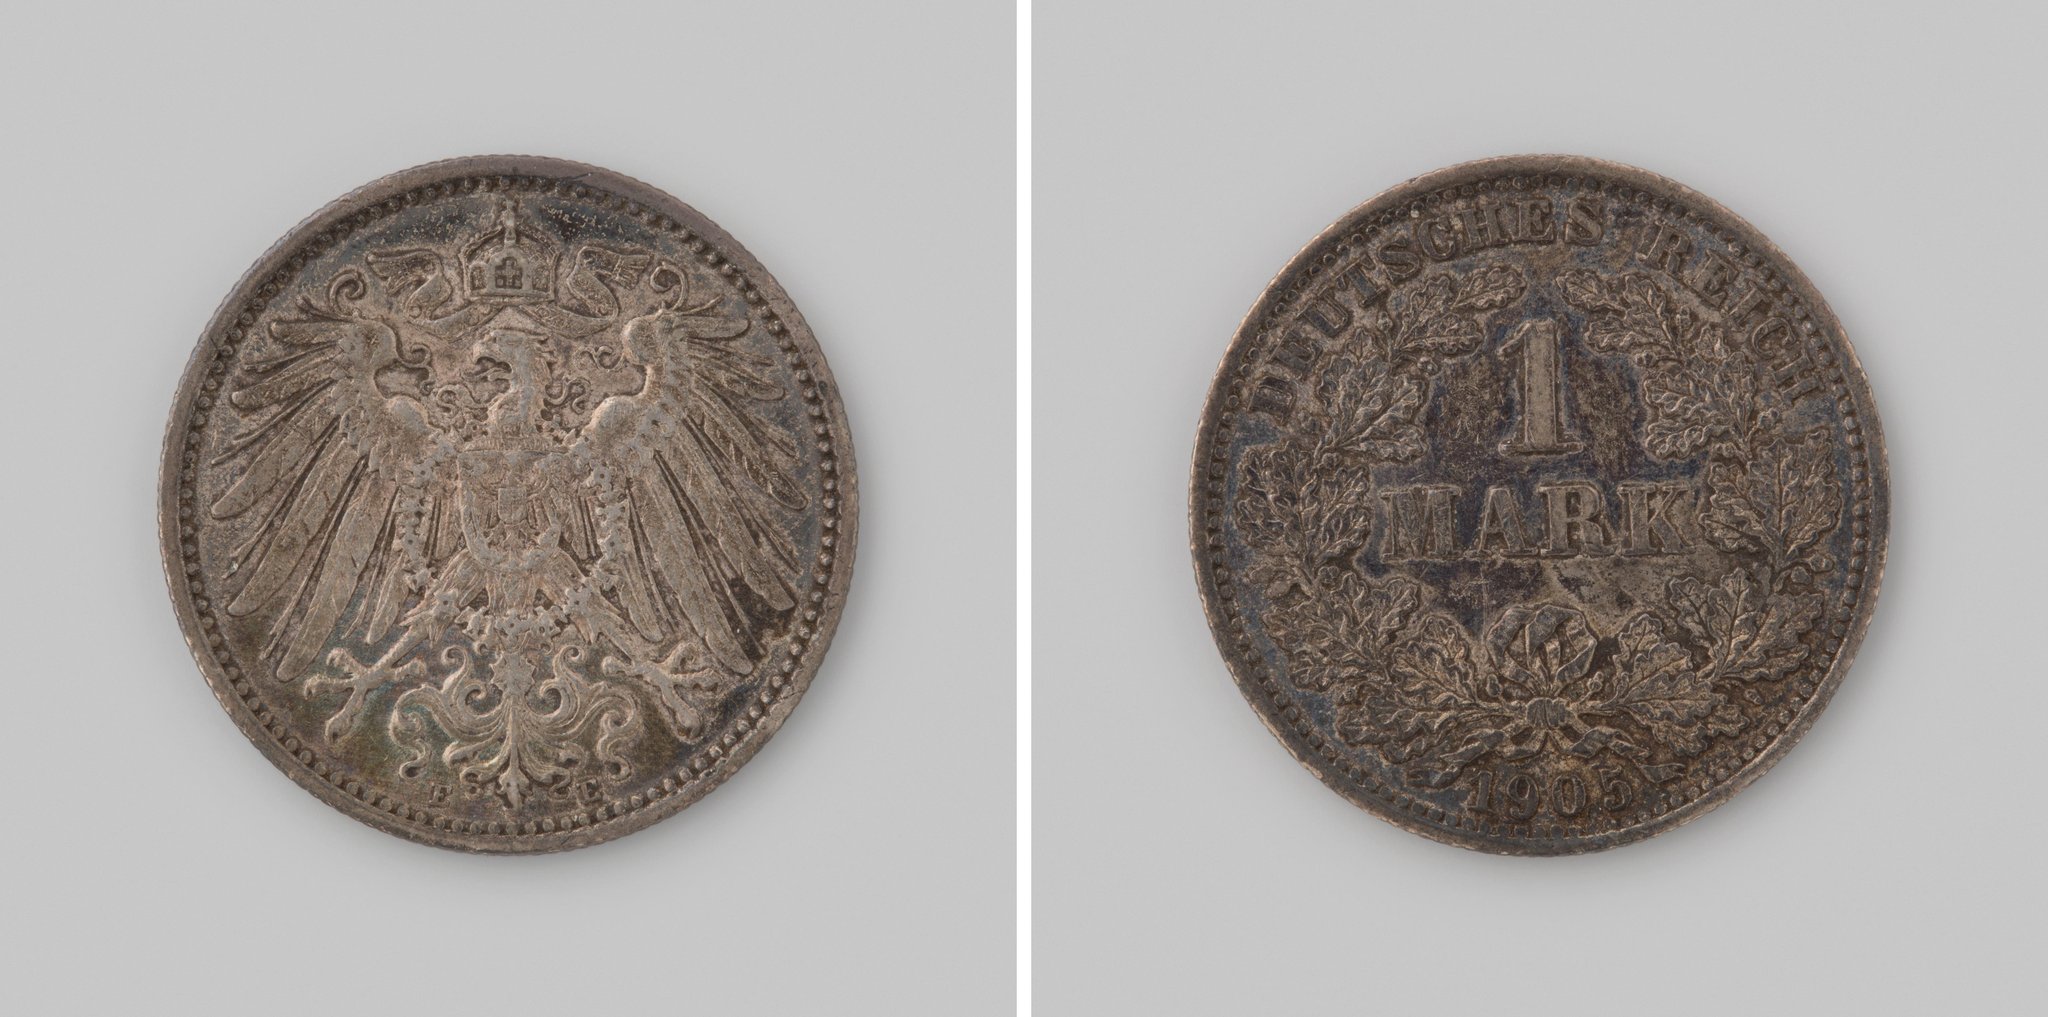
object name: coin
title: Mark uit het Duitse Rijk, 1905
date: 1876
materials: silver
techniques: striking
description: Zilveren munt. Voorzijde: gekroonde enkelkoppige adelaar naar links met op borst door keten van orde met juweel omhangen samengesteld wapenschild. Daaronder twee letters E. Keerzijde: binnen twee samengebonden eiketakken waarde-aanduiding in twee regels. Jaartal onderaan. Kartelrand. Geslagen te Muldenhütte.